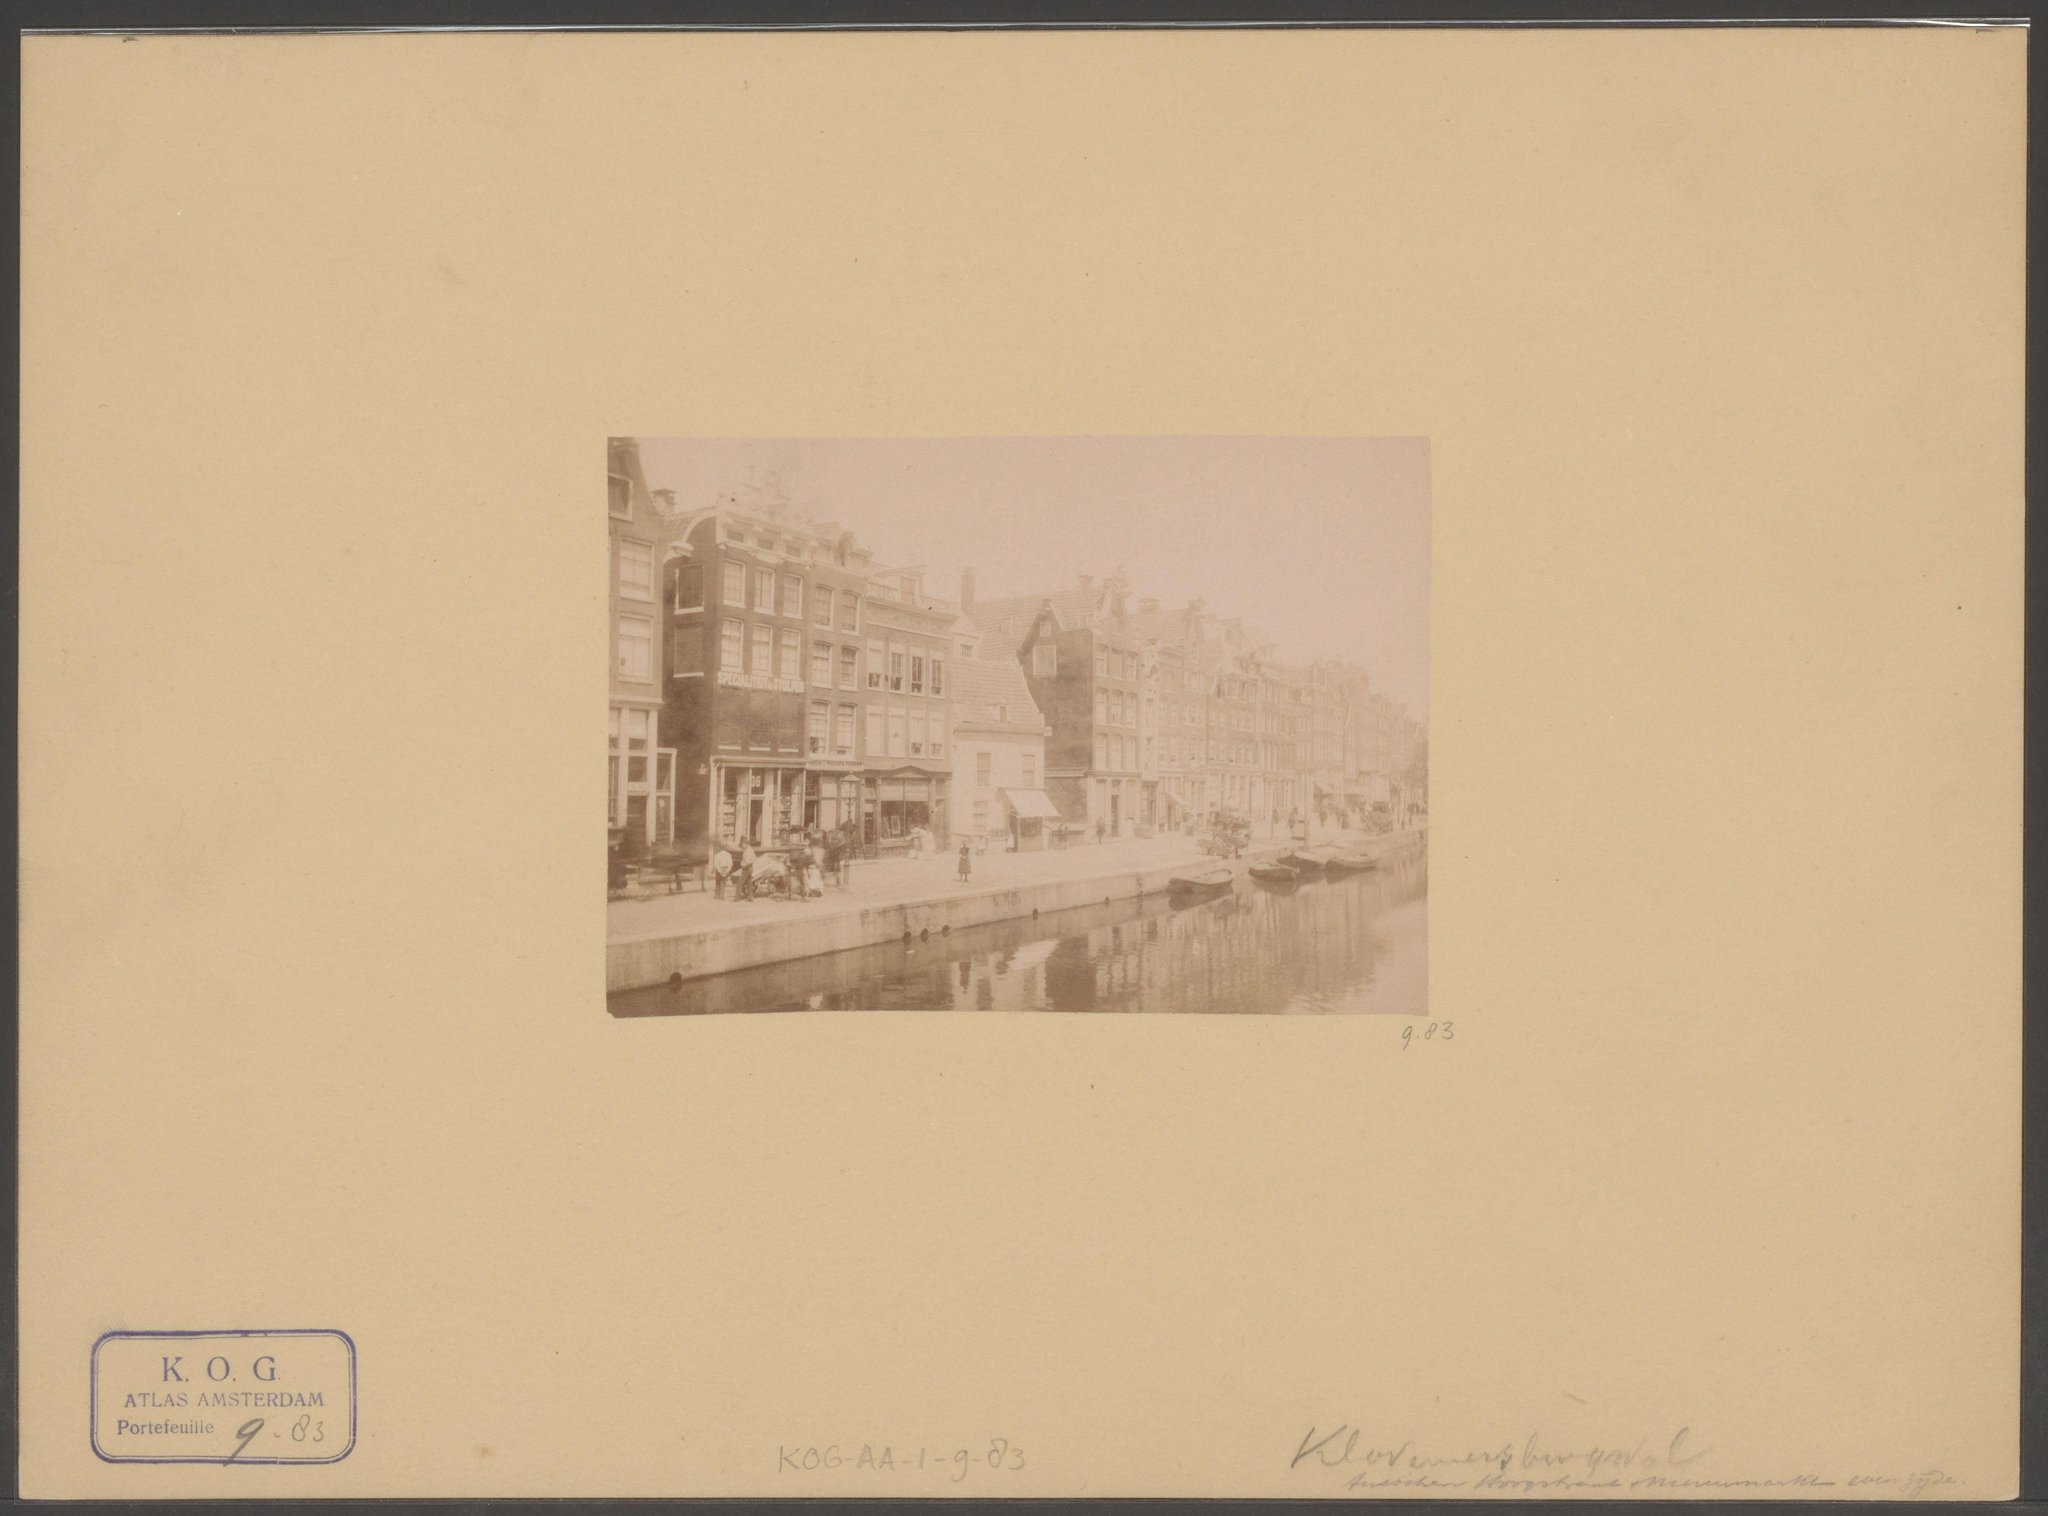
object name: photograph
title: Gezicht op de Kloveniersburgwal tussen de Hoogstraat en de Nieuwmarkt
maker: Anonymous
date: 1850-1915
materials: cardboard, paper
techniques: albumen print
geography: amsterdam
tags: city-view in general; 'veduta', canal, the usual house or row of houses, street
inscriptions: collector's mark: ‘9.83’ Lugt 1641b, inscription: ‘Kloveniersburgwal / tusschen Hoogstraat nieuwmarkt even zijde.’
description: Onderwerpsrubriek binnen de Atlas Amsterdam: Kadijksplein, Karthuizerkerkhof, Kattegat, Kattenburg, Kapelsteeg O.Z., Enge Kerksteeg, Kerkstraat, Kinkerstraat, Kolk O.Z., Koningsplein, Kromboomsloot [Krom Boomssloot], Kostverlorenkade, Kwakersdwarspad, Kalverstraat, Keizersgracht (v.d. Brouwersgracht – Amstel), Klerensloot (Gedempte), Klimopstraat, Kloveniersburgwal, Kraansluis.